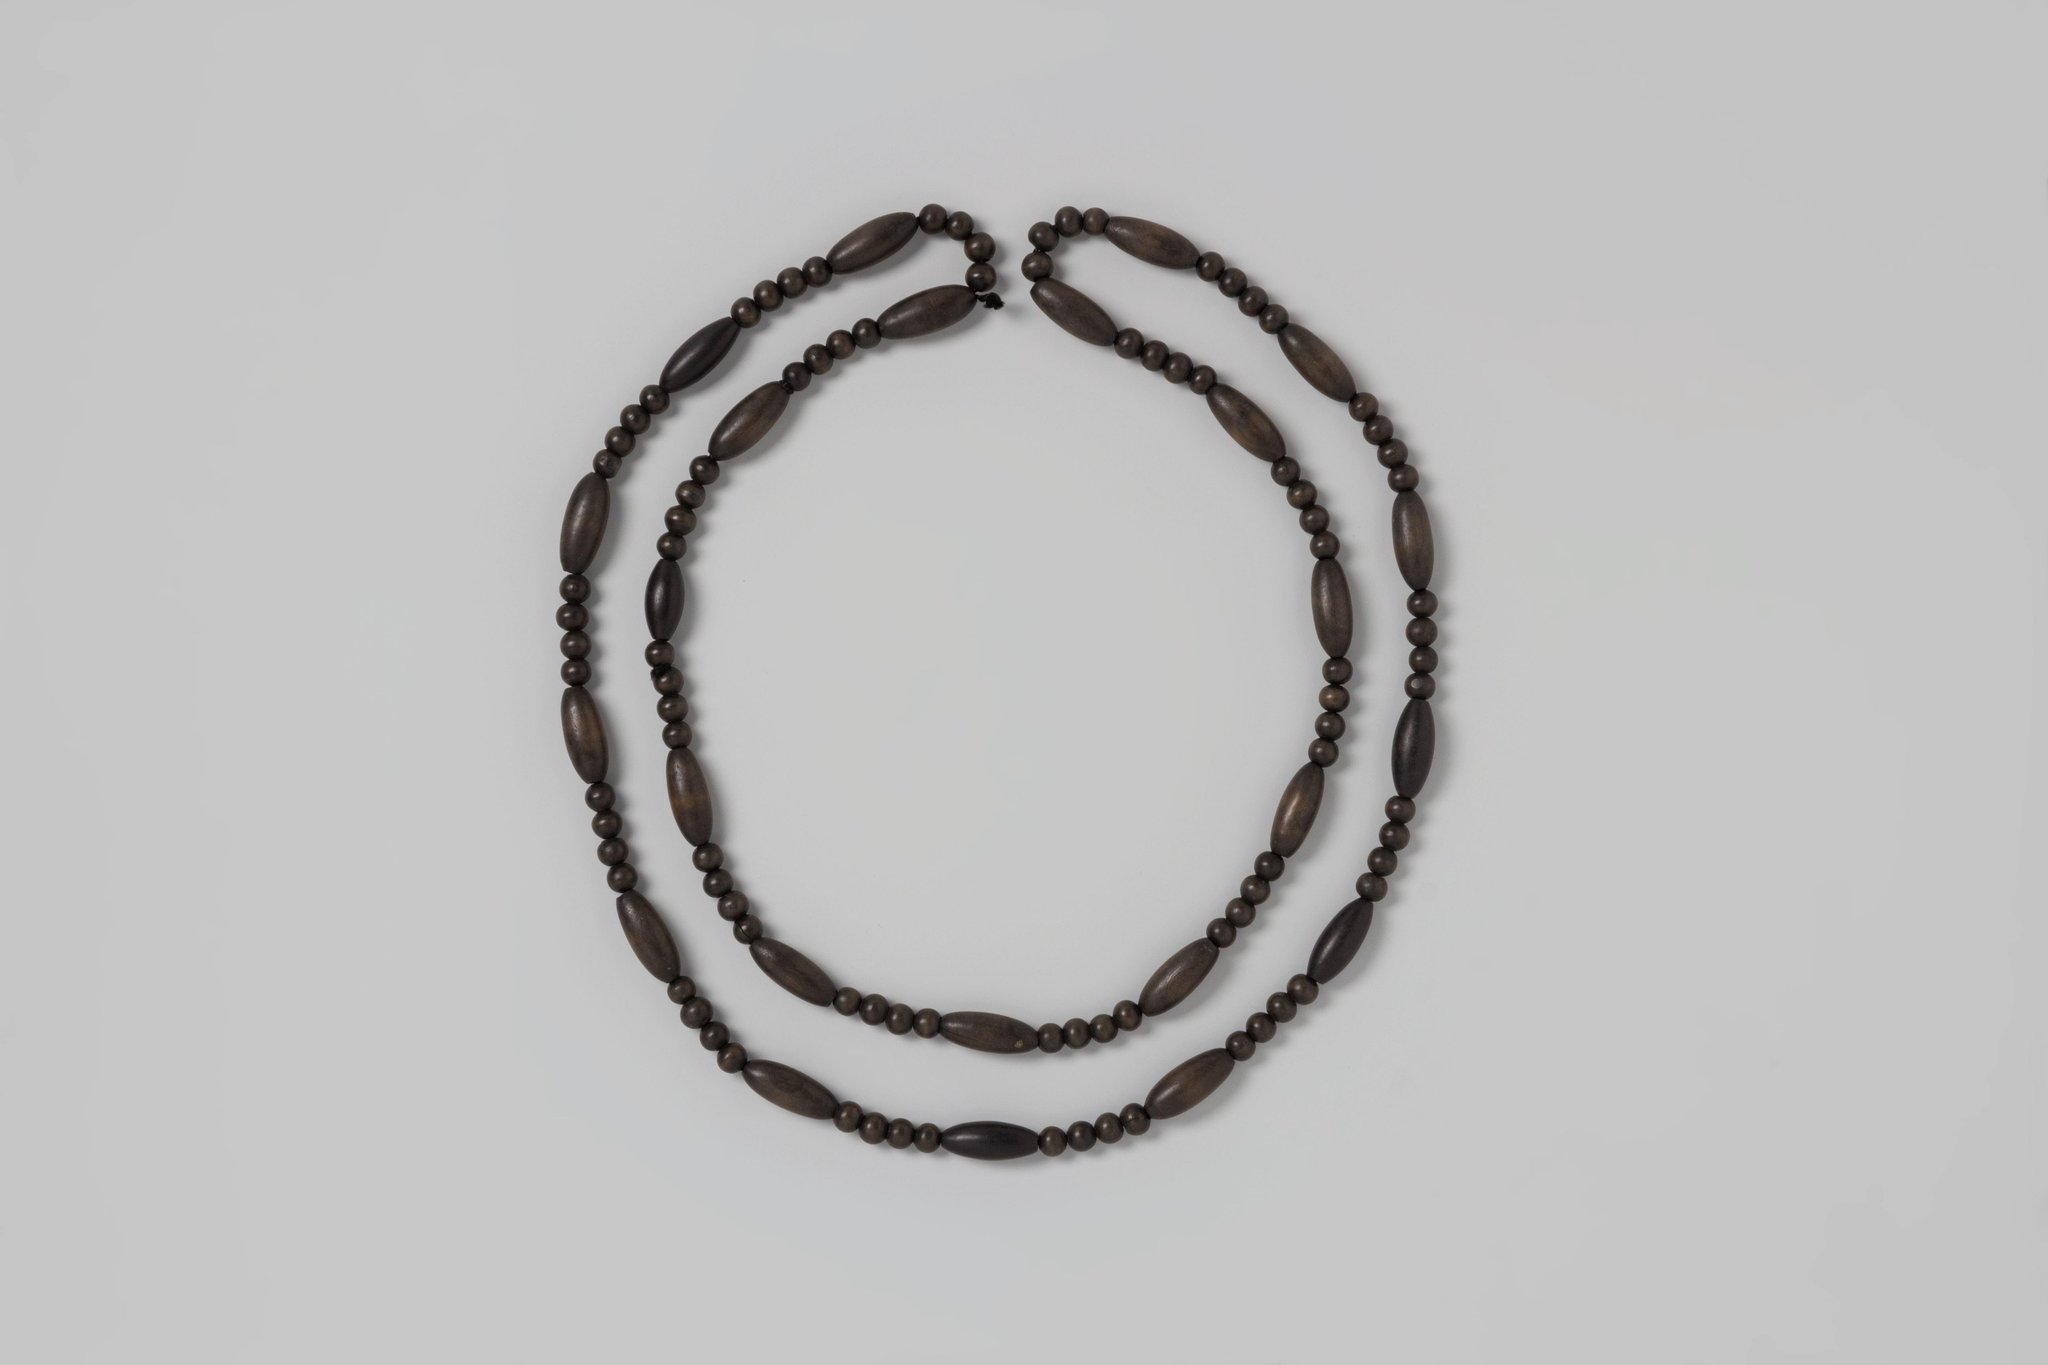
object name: chain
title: Ketting van zwarte houten kralen, afwisselend vier ronde en één ovale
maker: Anonymous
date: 1900-1920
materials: wood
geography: netherlands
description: Ketting van zwarte houten kralen, afwisselend vier ronde en één ovale.